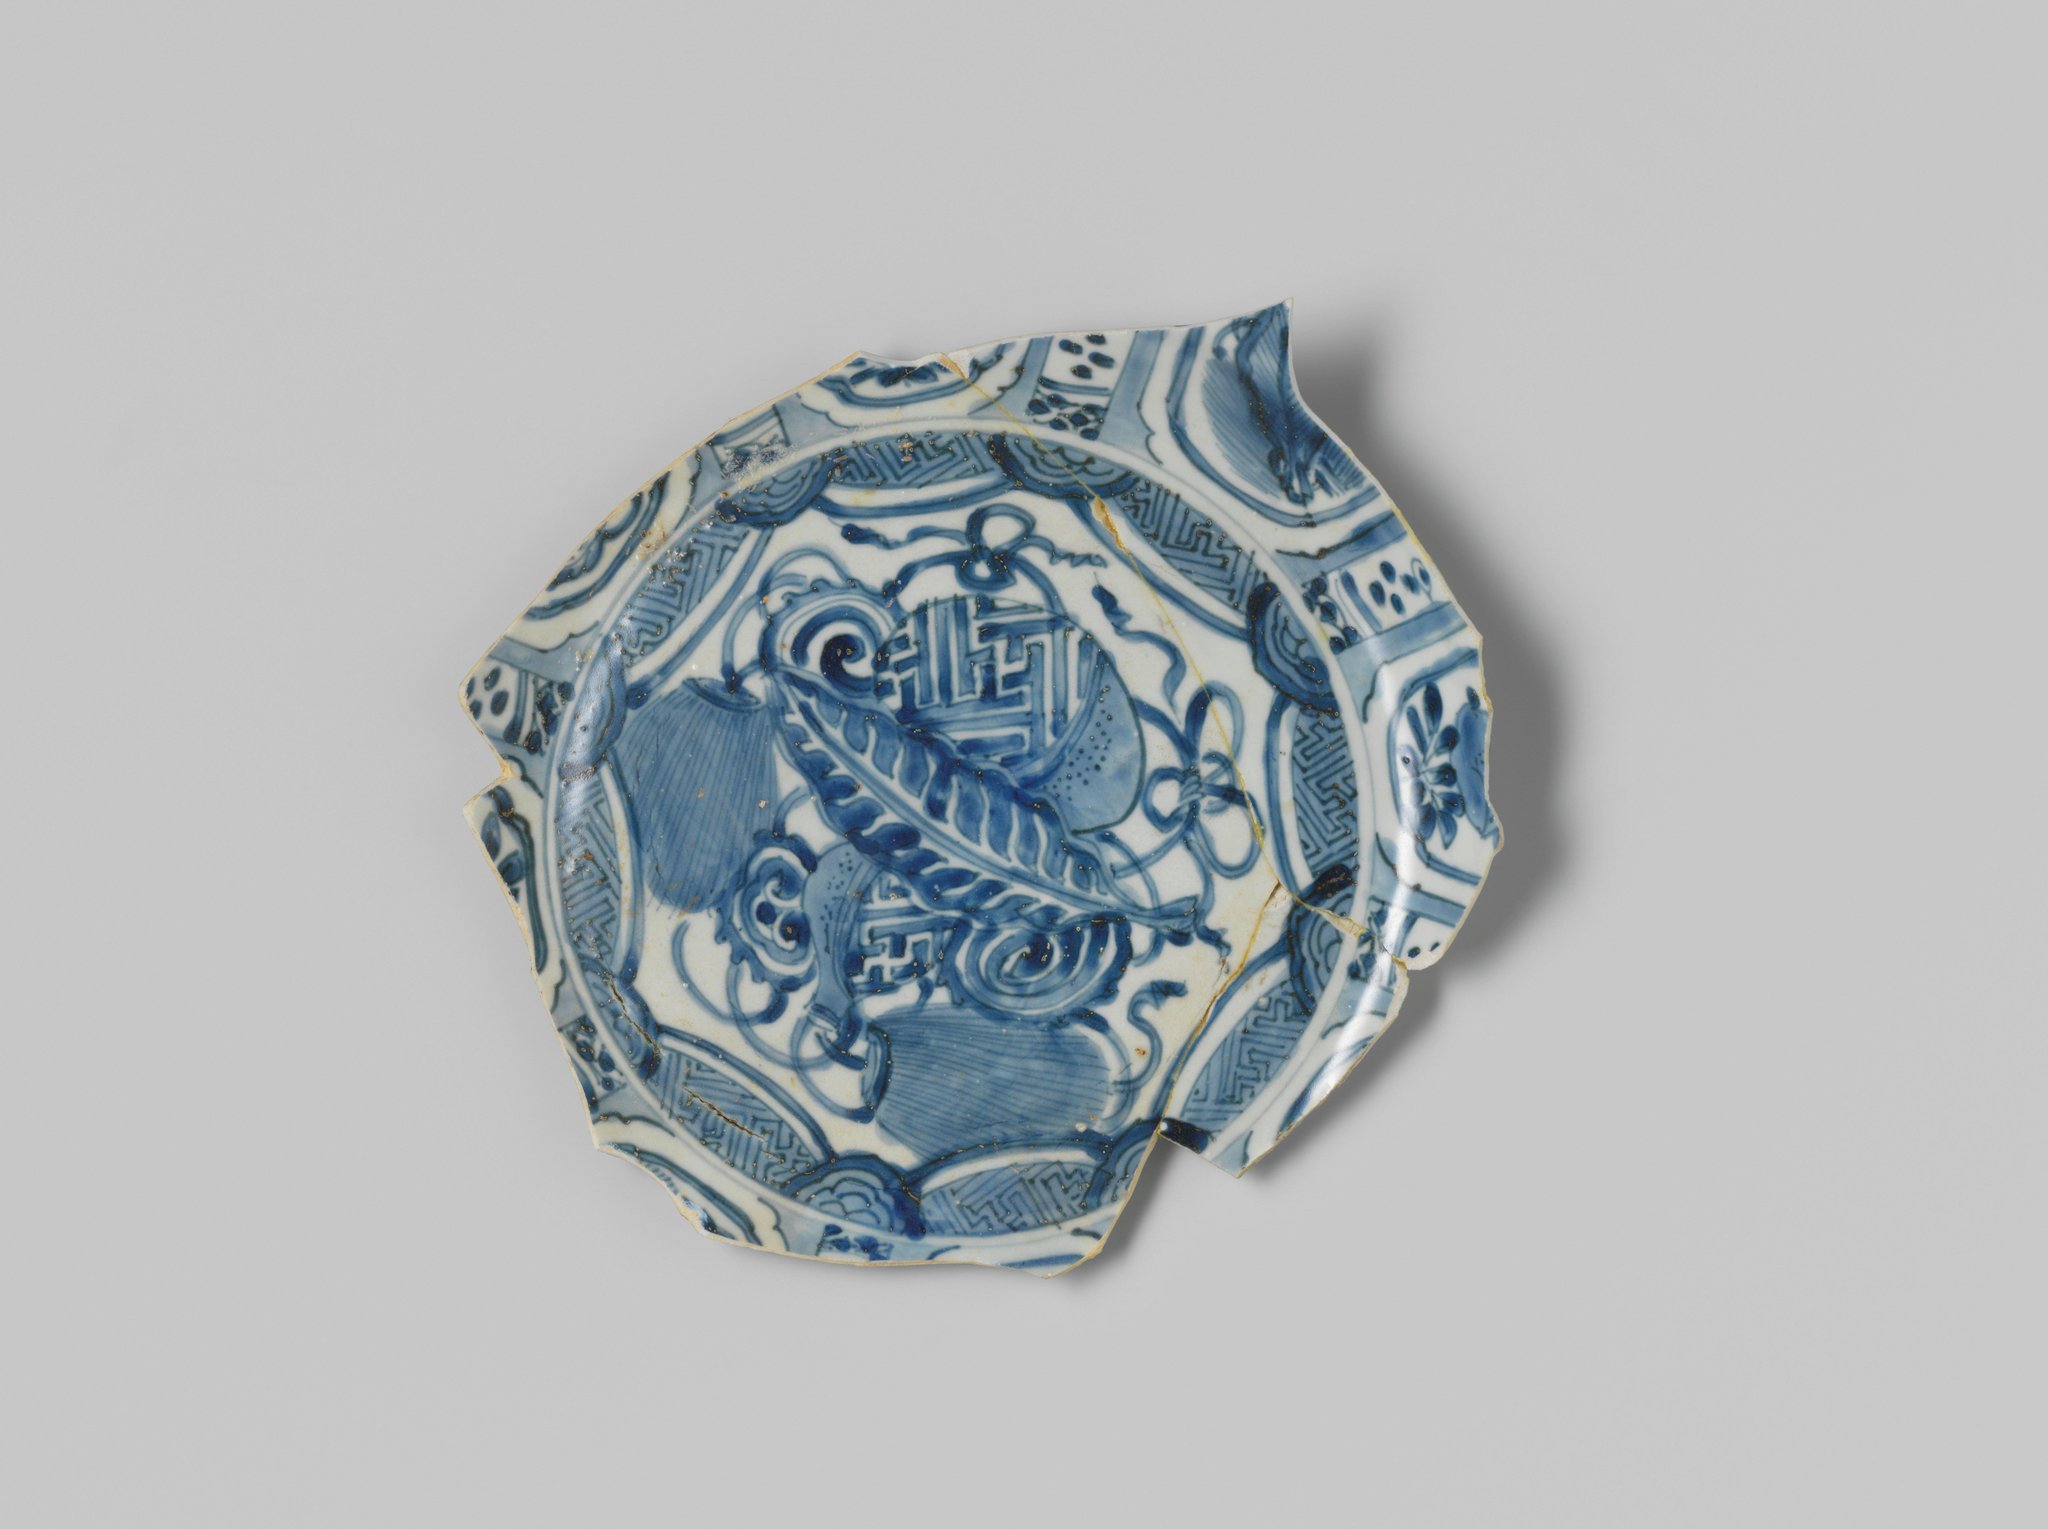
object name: sherd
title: Fragment bord uit V.O.C.-schip de 'Witte Leeuw'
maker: Anonymous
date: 1613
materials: bone china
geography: jingdezhen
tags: verenigde oostindische compagnie, sint-helena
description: Bord uit V.O.C.-schip de 'Witte Leeuw', 30% aanwezig; de wand ontbreekt. De scherf is glasachtig wit en kent weinig ingebakken vuil. Het glazuur is blauw getint. De bodem is ongeglazuurd. De voetring staat naar binnen en is gefacetteerd. De lip is geschulpt.